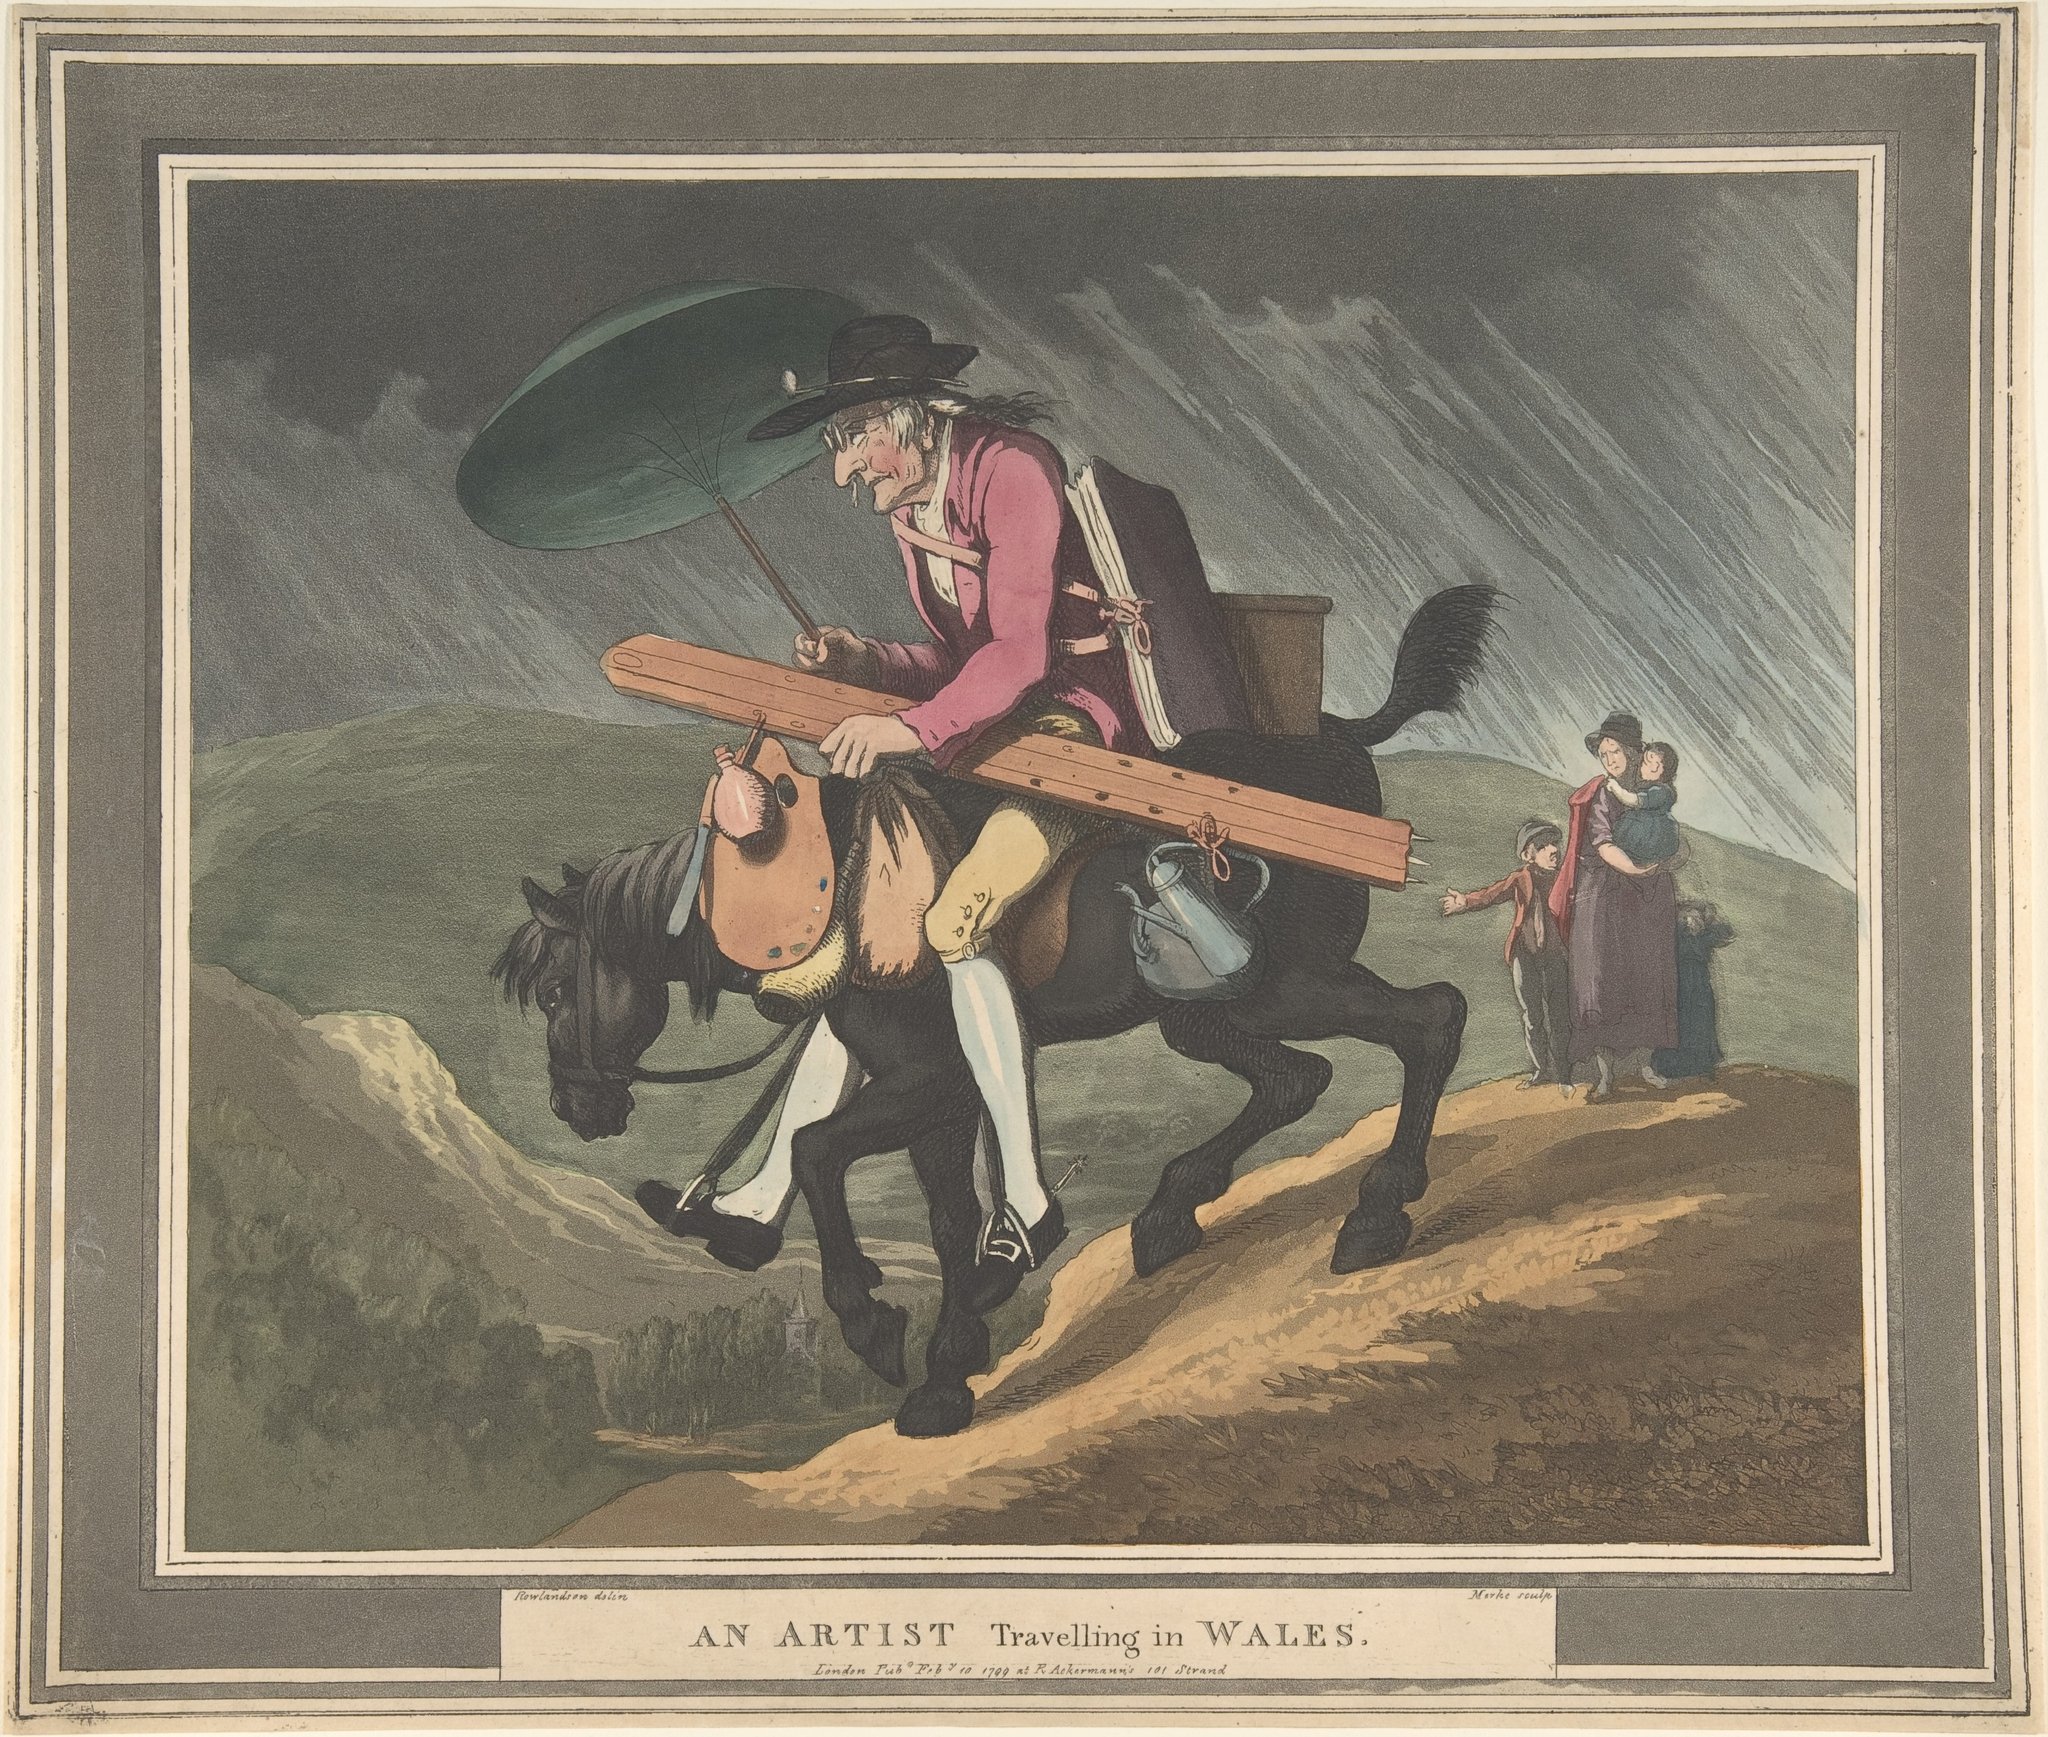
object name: print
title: An Artist Travelling in Wales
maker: thomas rowlandson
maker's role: artist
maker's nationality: british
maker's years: 1757-1827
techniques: aquatint, etching, hand coloring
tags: infants,men,women,horses,artists